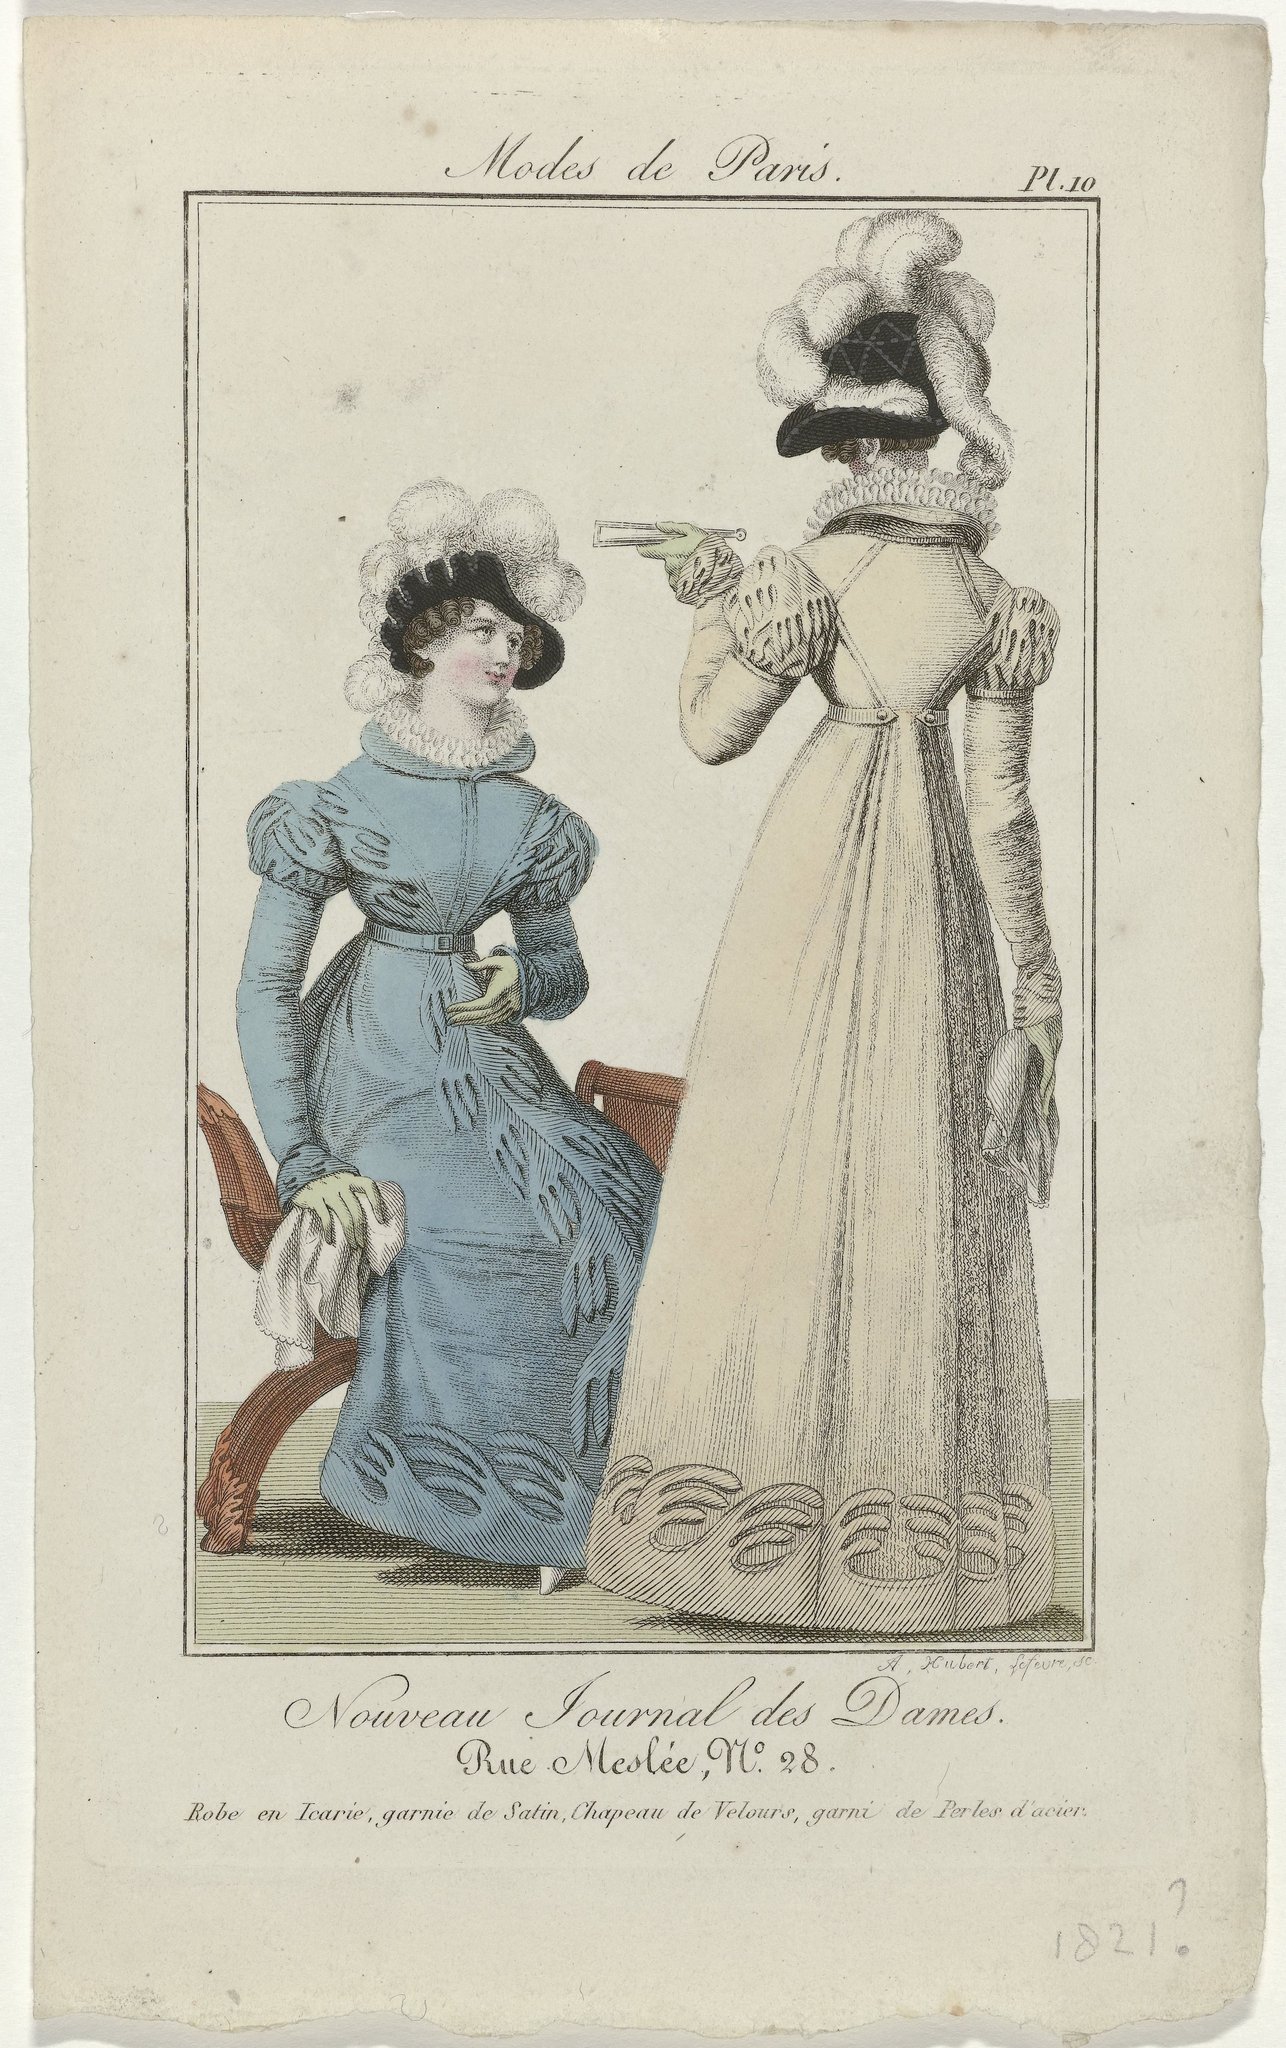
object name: fashion print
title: Nouveau Journal des Dames, 1821, Pl. 10 : Robe en Icarie, garnie de Satin (...)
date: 1821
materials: paper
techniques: engraving, hand coloring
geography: paris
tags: handkerchief (+ women's clothes), ornamental parts of clothing (+ women's clothes), fashion plates, head-gear: hat (+ women's clothes), gloves, mittens, etc. (+ women's clothes), dress, gown (+ women's clothes), stool, fan (+ women's clothes)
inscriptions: title: ‘Nouveau Journal des Dames.’, caption: ‘Robe en Icarie, garnie de Satin, Chapeau de Velours, garni de perles d'acier.’, title: ‘Modes de Paris.’, address: ‘Rue Meslée, No. 28.’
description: Vrouw, zittend op een tabouret, in een japon van 'Icarie' gegarneerd met satijn. Op het hoofd een hoed van fluweel, versierd met metalen kralen en struisveren. Verdere accessoires: handschoenen, ceintuur met gesp, zakdoek, waaier. Naast haar staat een vrouw, op de rug gezien, gekleed in eenzelfde japon. Prent uit het modetijdschrift Nouveau Journal des Dames, Parijs, van 5 juli 1821 tot eind december 1821. Van januari 1822 tot 1868 was het modetijdschrift getiteld: Petit Courrier des Dames.